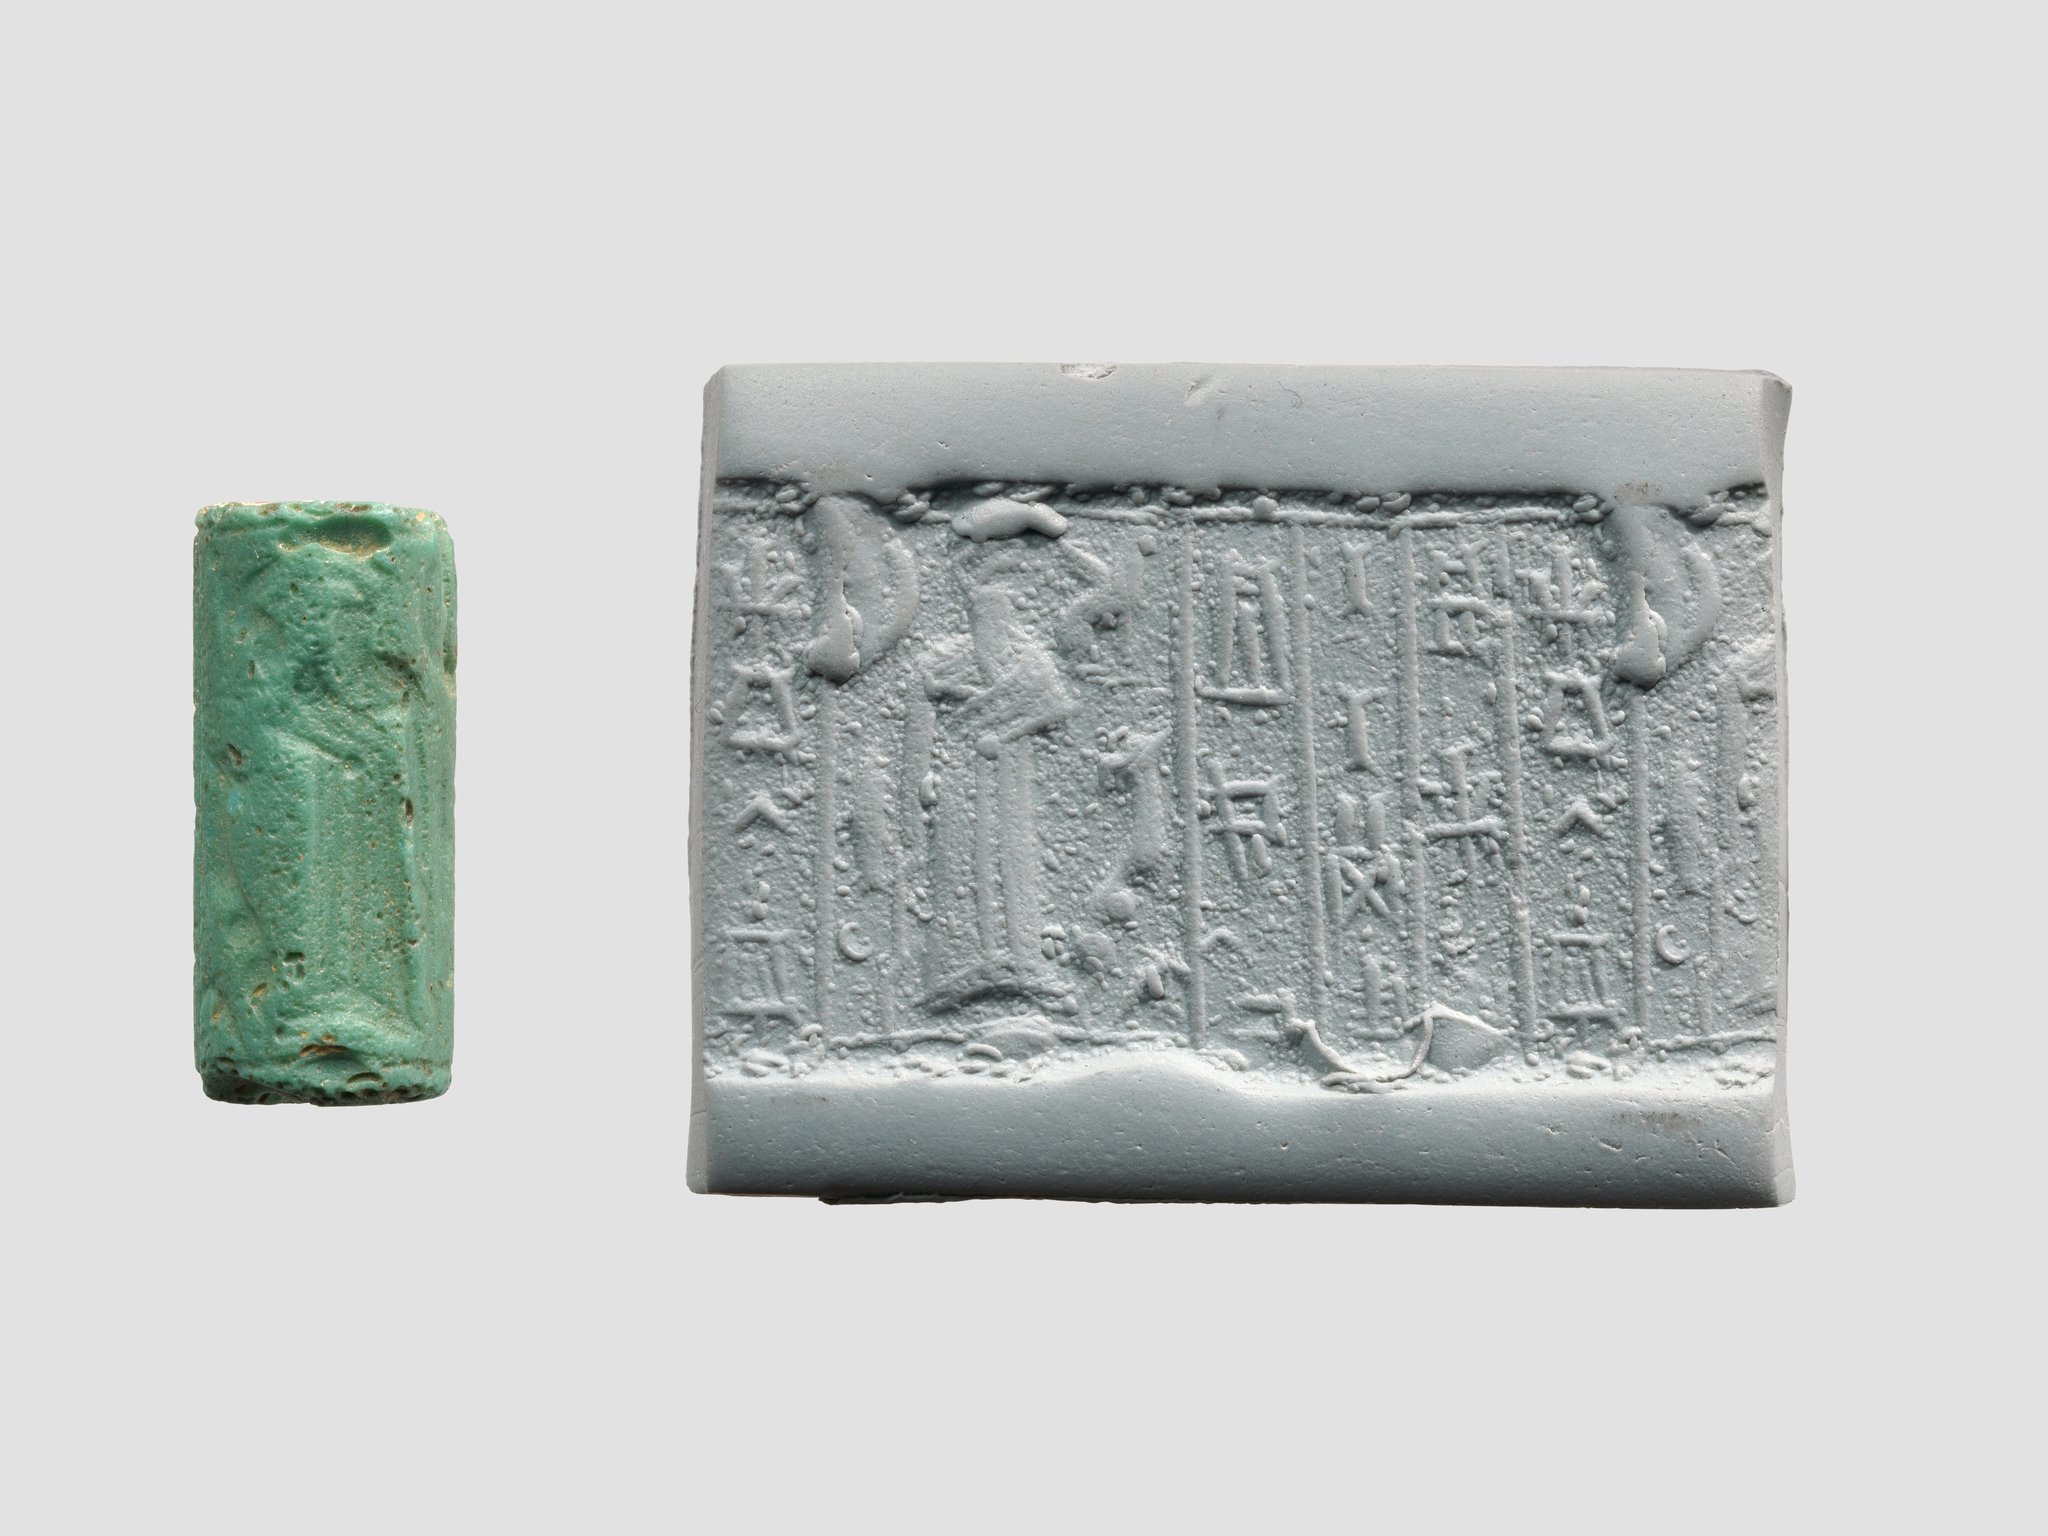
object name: cylinder seal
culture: kassite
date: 1600-1401 BCE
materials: faience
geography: iran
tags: animals